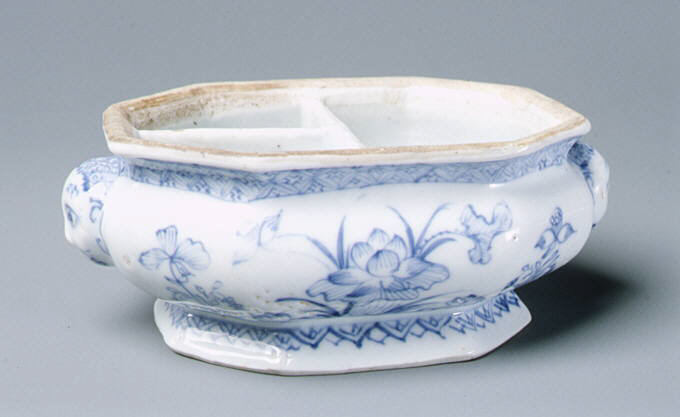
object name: spice box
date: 1720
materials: hard paste porcelain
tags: flowers